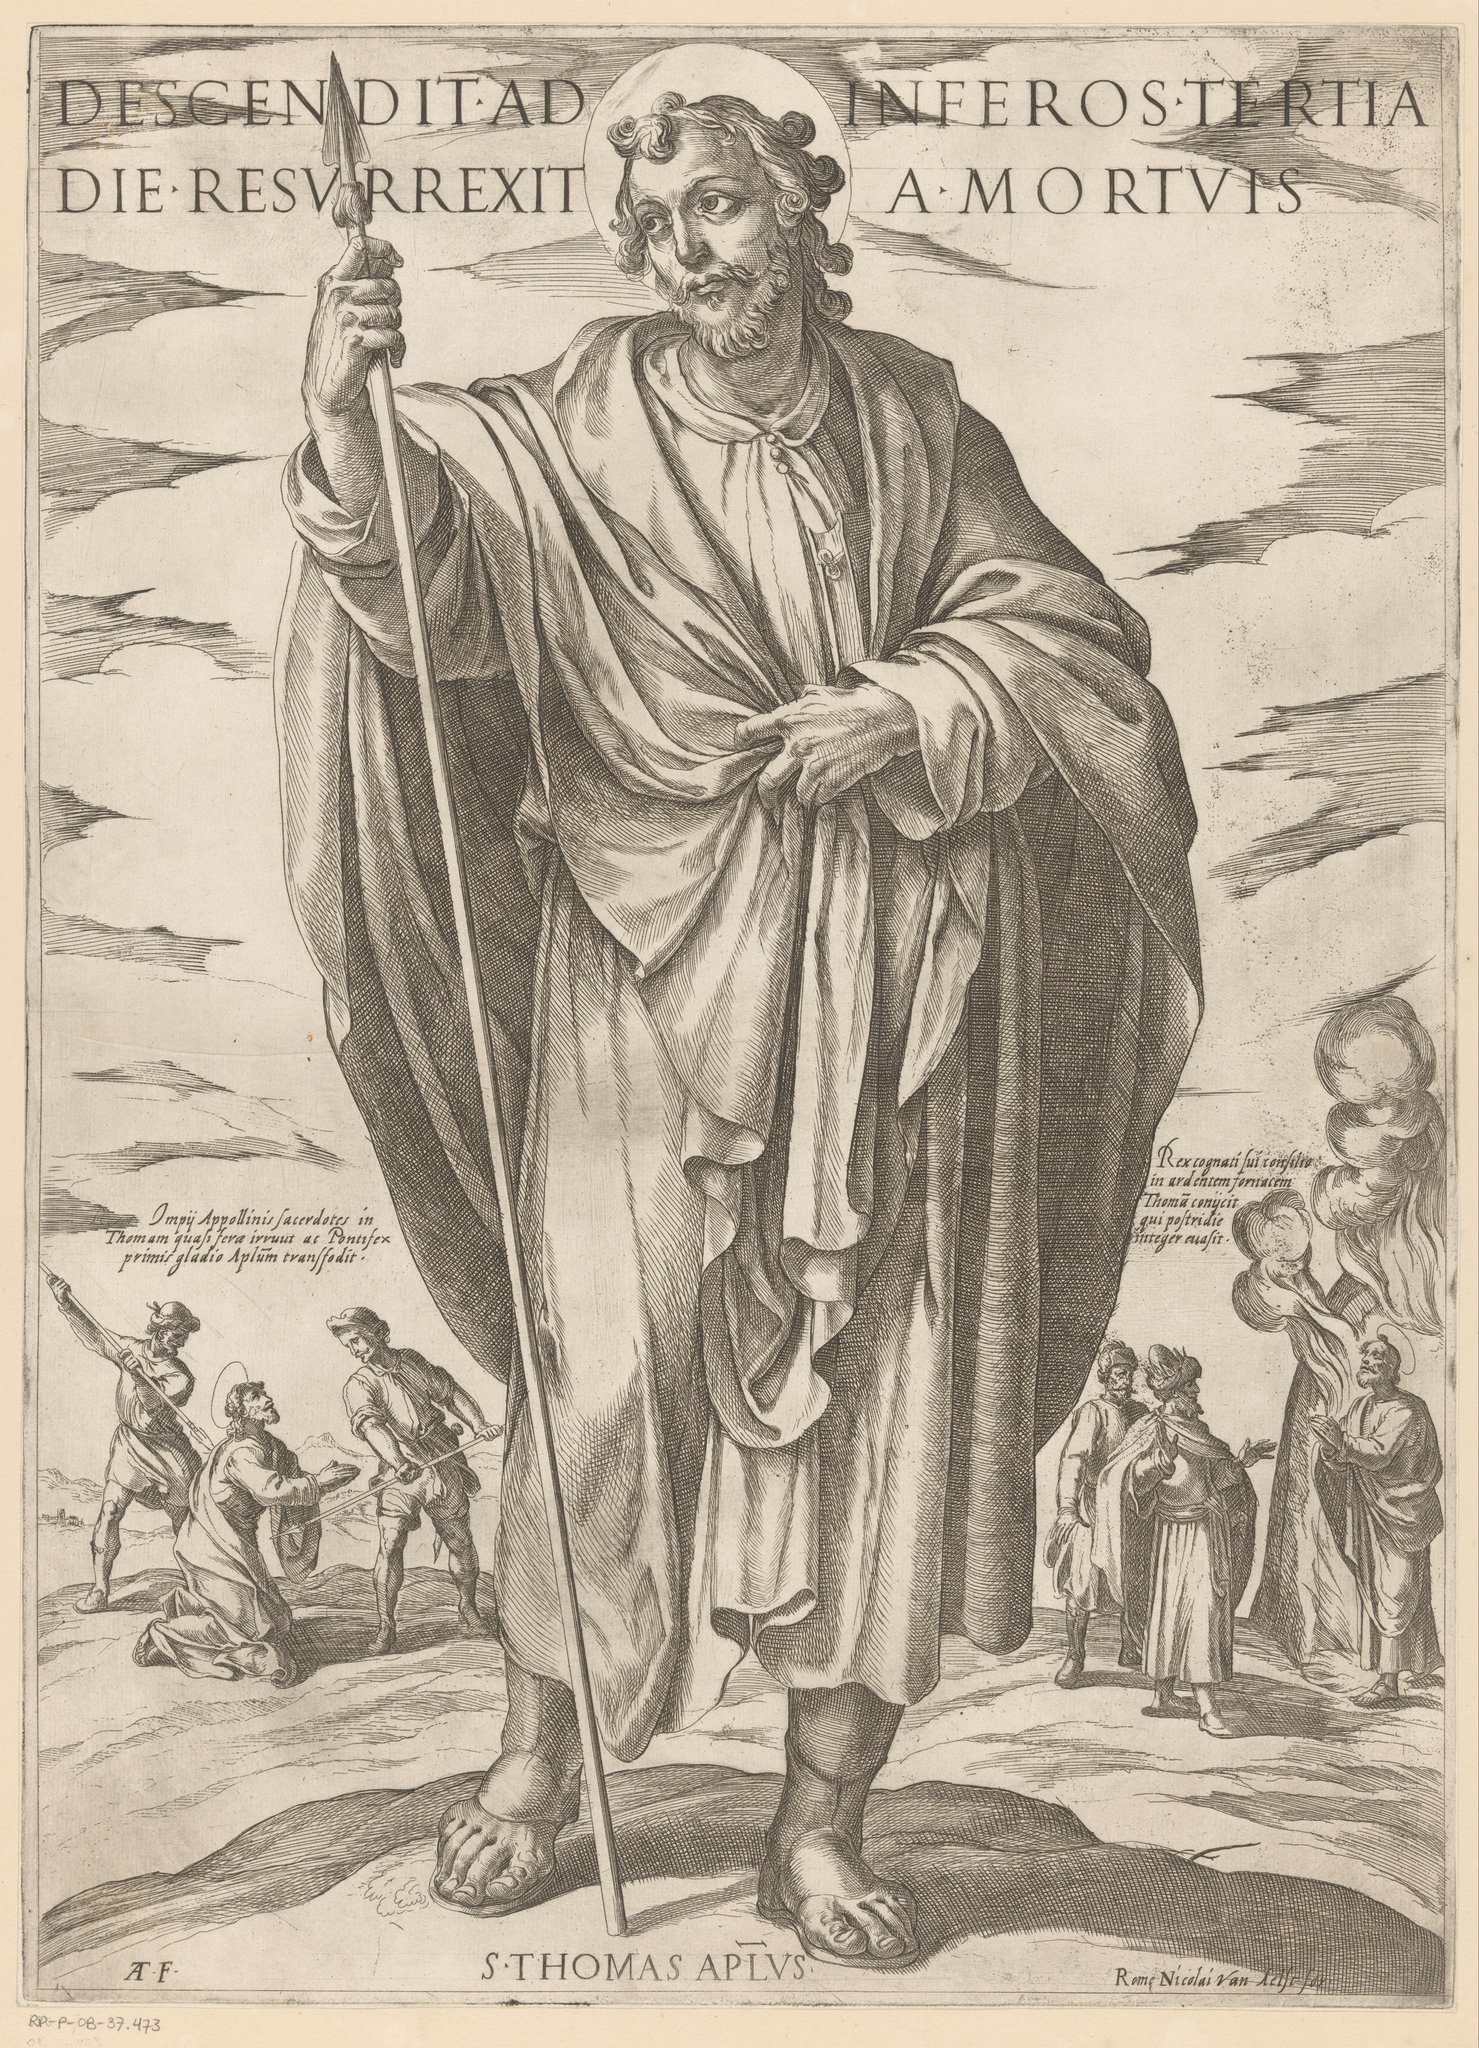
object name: print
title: Christus, Maria en de apostelen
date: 1565-1630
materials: paper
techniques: etching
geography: rome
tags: the apostle thomas; possible attributes: book, chalice, girdle, heart, lance or spear, scroll, square, stones, miracles of thomas, martyrdom and death of thomas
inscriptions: collector's mark: Lugt 240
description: De heilige Tomas met boek en speer. Op de achtergrond links wordt Tomas dood gestoken door twee mannen met speren. Op de achtergrond rechts verricht Tomas een wonder in India.